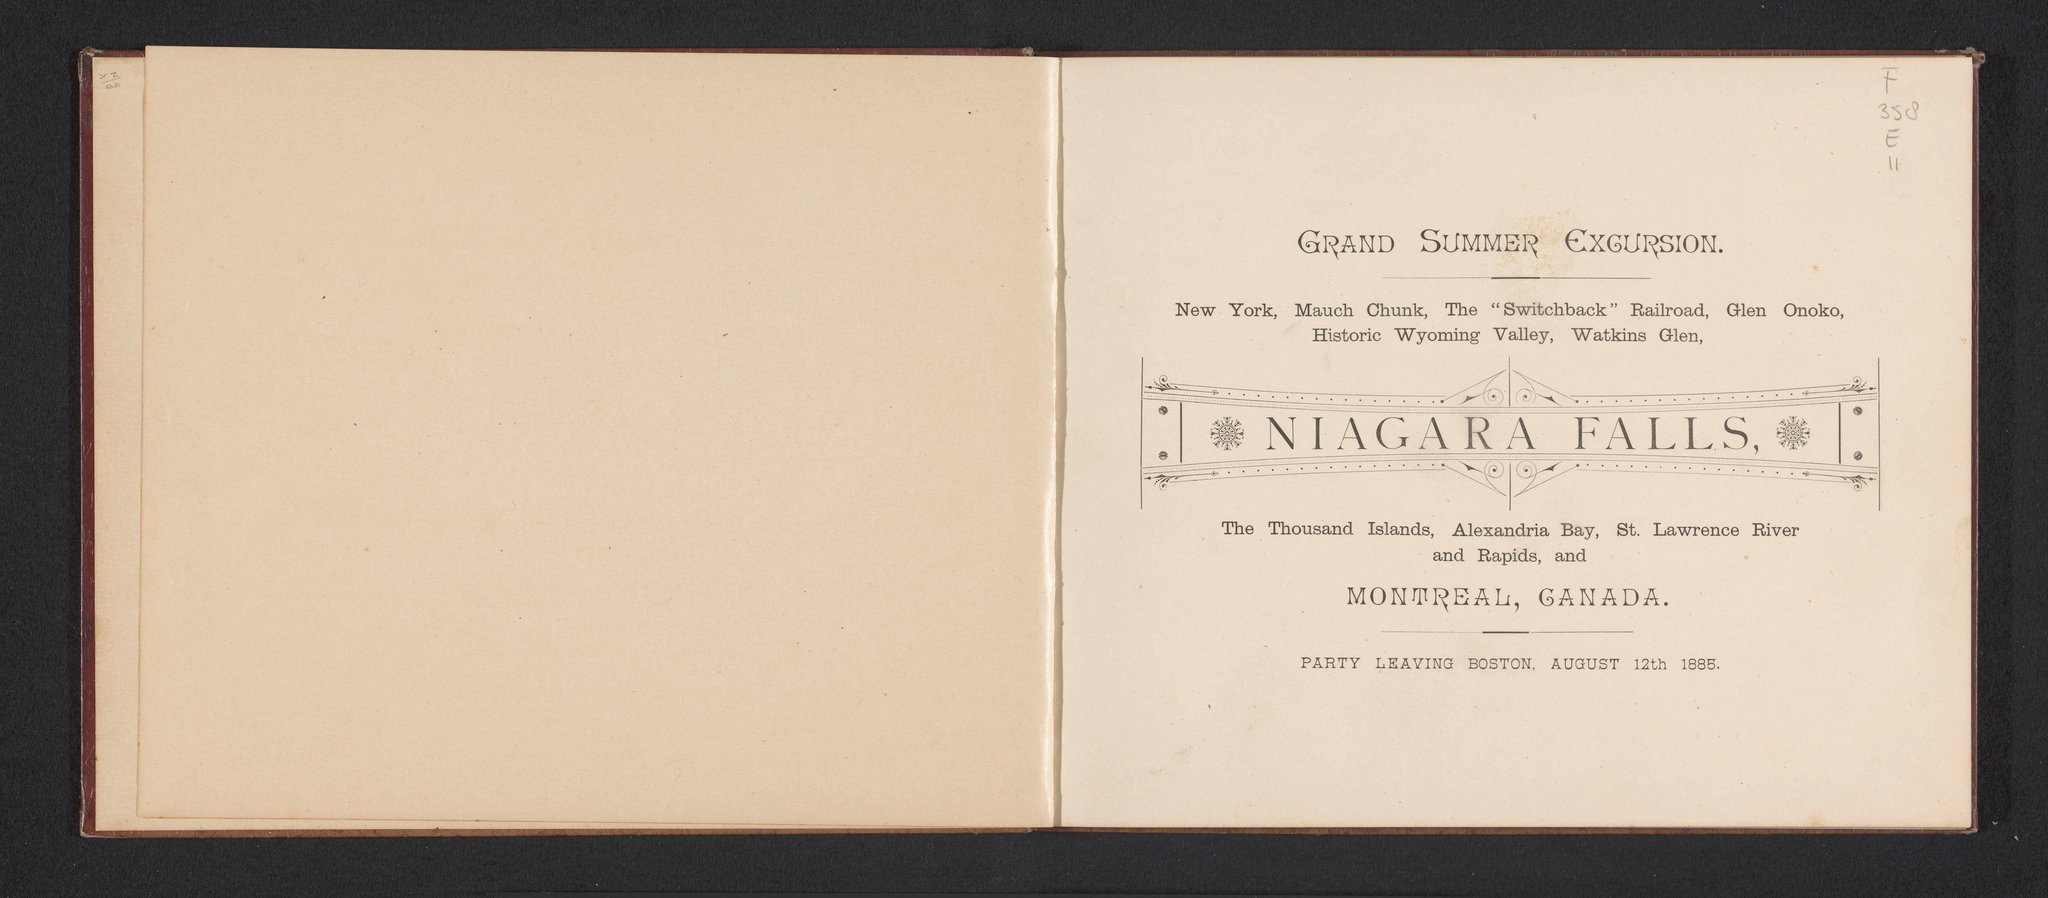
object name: book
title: Grand summer excursion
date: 1885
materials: cardboard, linen, paper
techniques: photograph